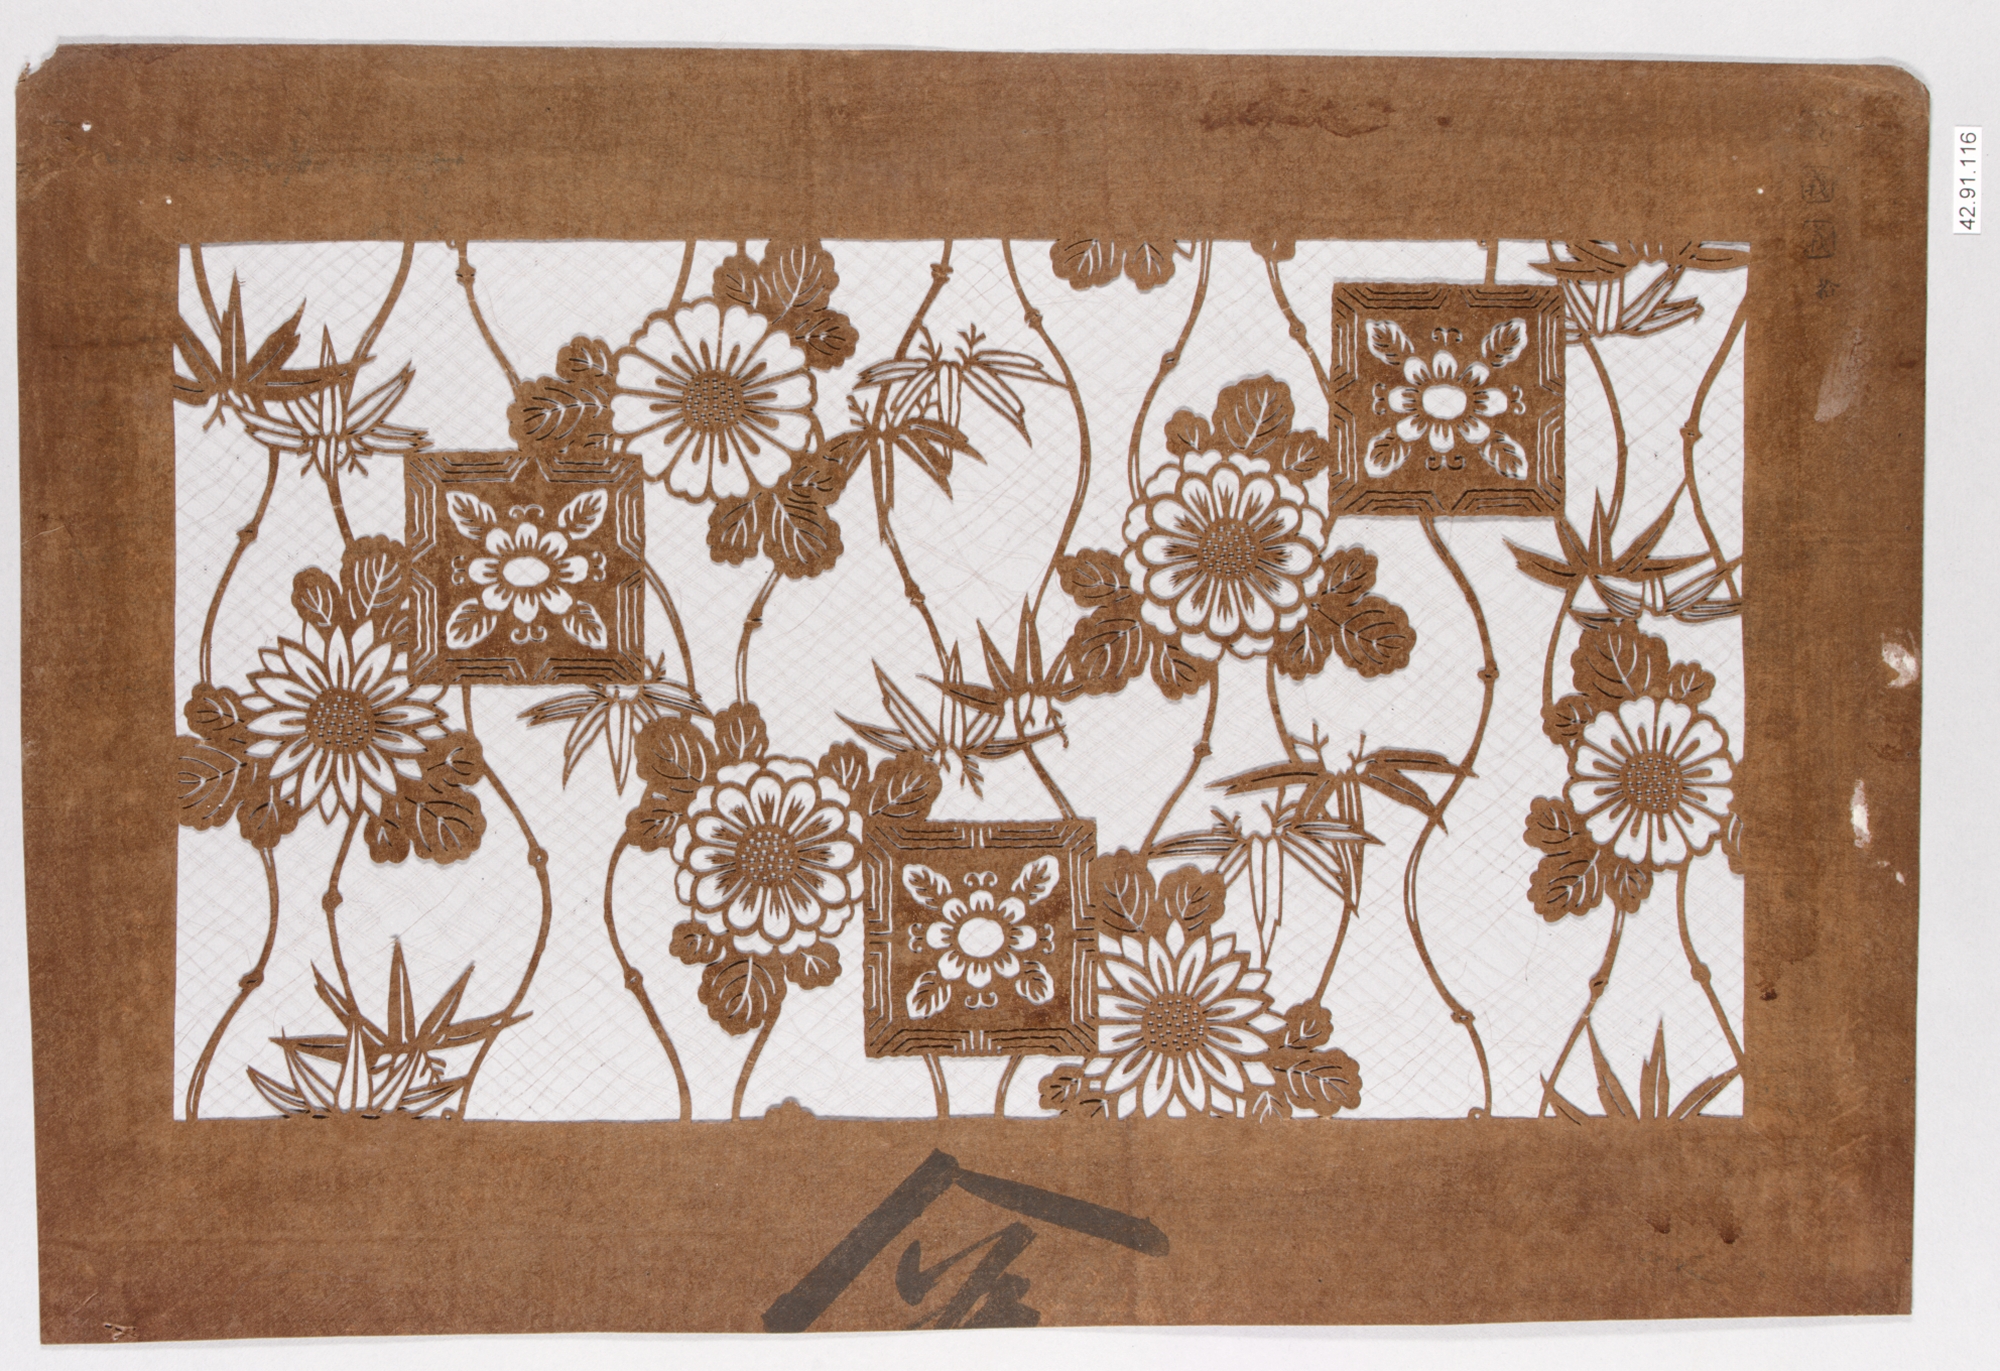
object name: stencil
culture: japanese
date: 1801-1900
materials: paper, silk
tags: flowers